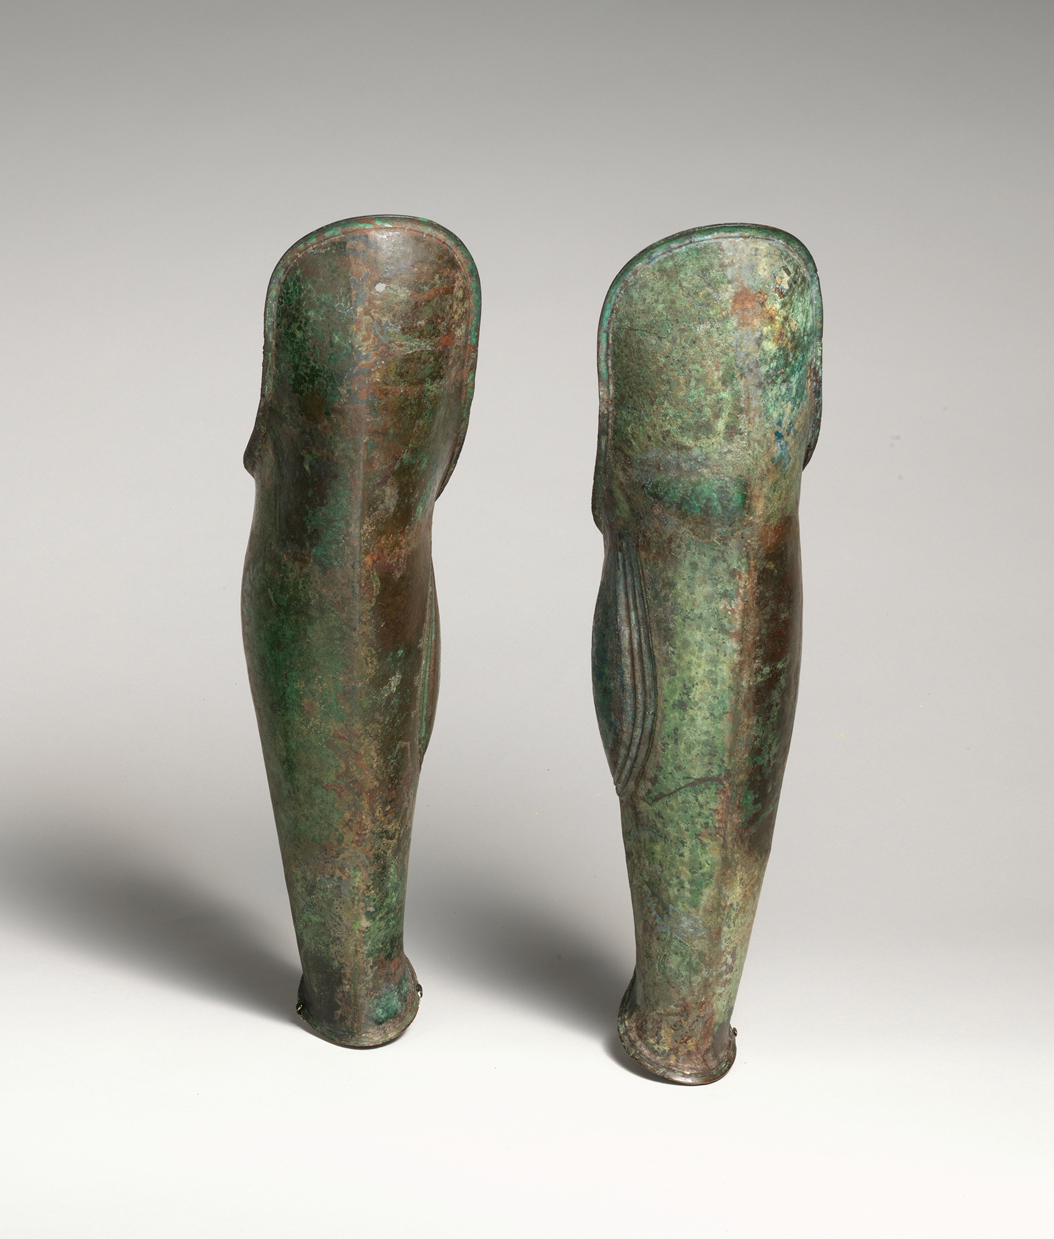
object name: greave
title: Pair of bronze greaves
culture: etruscan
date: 400-301 BCE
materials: bronze